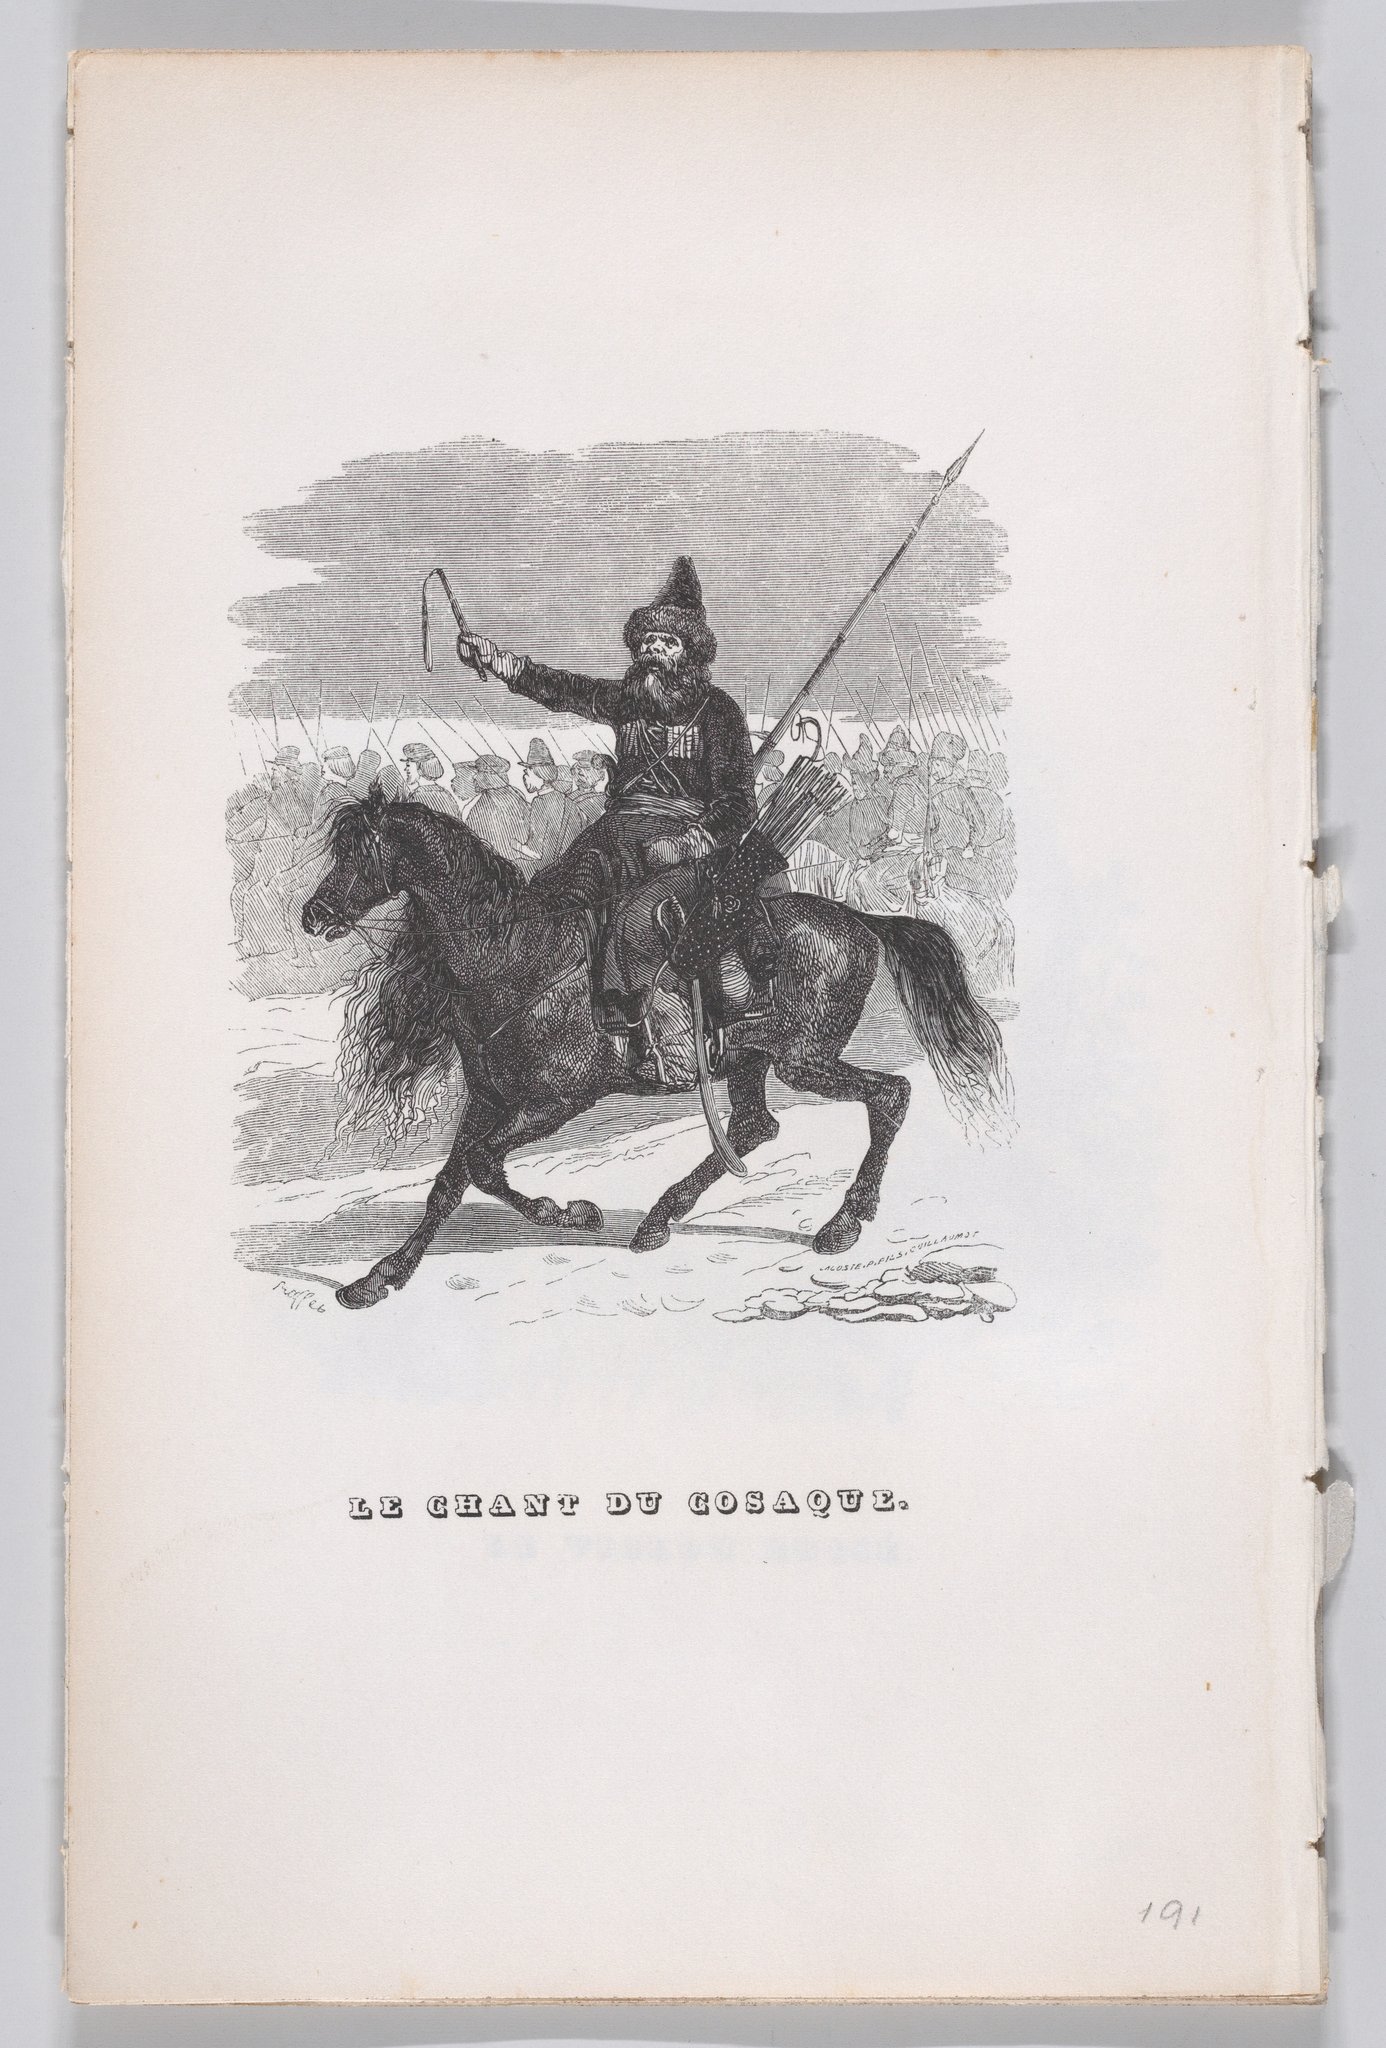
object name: print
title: The Song of the Cossack, from "The Complete Works of Béranger"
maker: j. j. grandville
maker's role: illustrator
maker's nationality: french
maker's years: 1803-1847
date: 1836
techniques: engraving